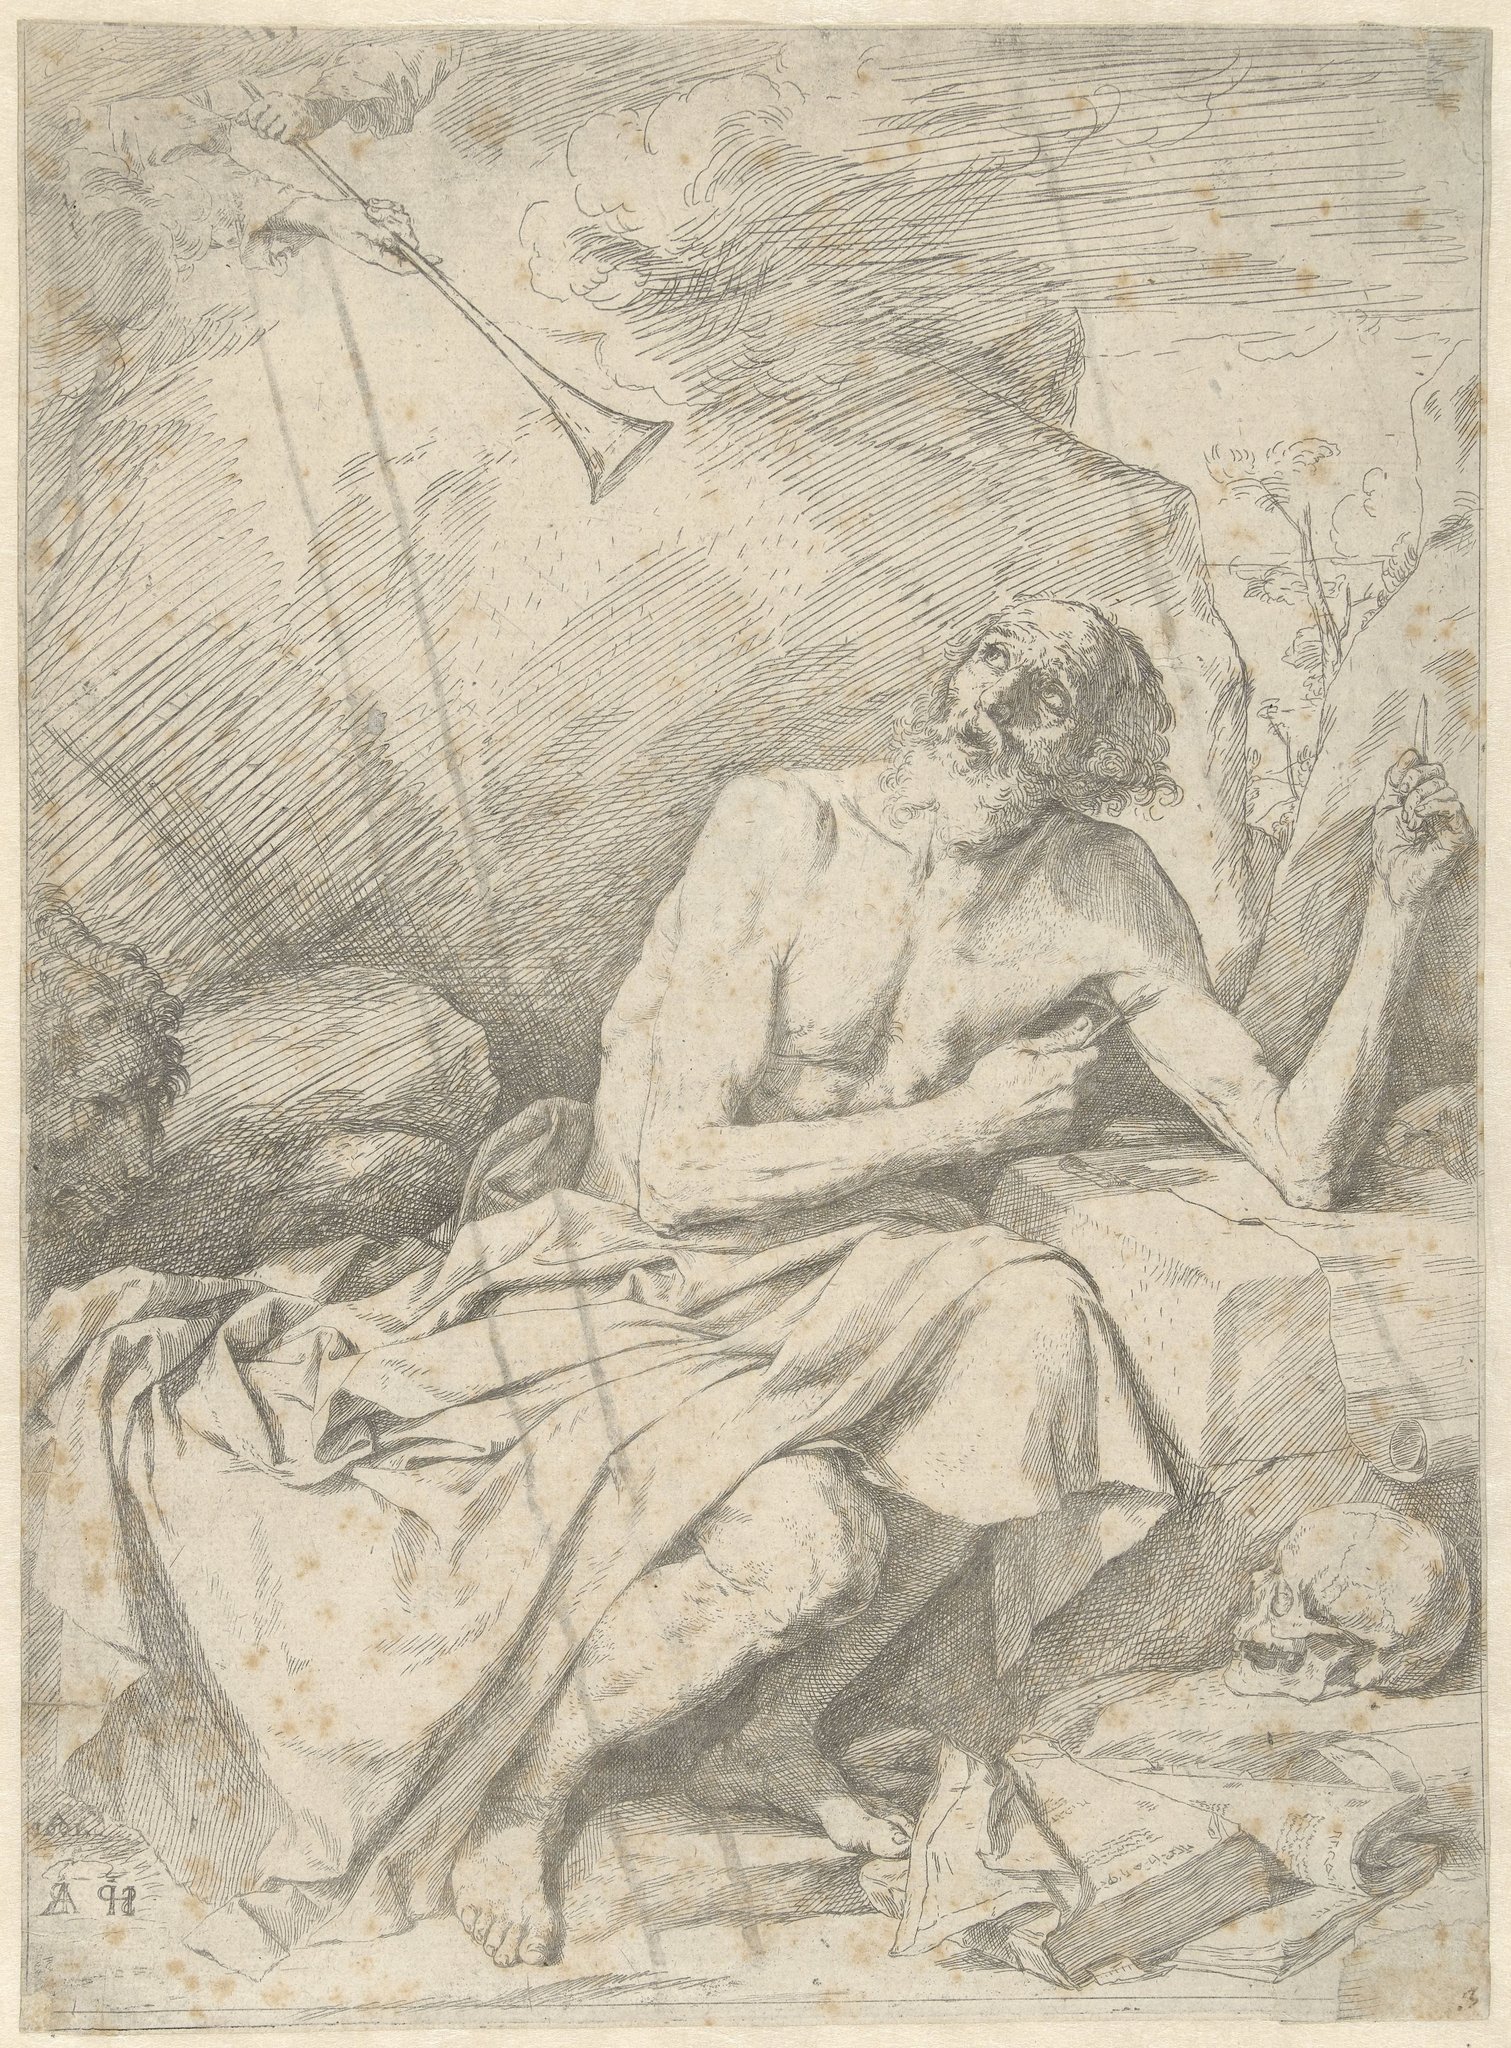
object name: print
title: Heilige Hieronymus en de trompet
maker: jusepe de ribera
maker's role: draughtsman, painter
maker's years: 1591-1652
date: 1621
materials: paper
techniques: printmaking, drypoint, engraving, etching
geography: naples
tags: st. jerome as penitent in the desert, half naked, kneeling before a crucifix and holding a stone in his hand to beat his breast; a skull (and other 'vanitas' symbols), sometimes a scorpion and a snake beside him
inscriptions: collector's mark: Lugt 10, number: ‘3’, collector's mark: Lugt 11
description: De heilige Hieronymus zittend in de wildernis, met zijn boeken, een schedel en de leeuw. Uit een wolk aan de hemel steken twee handen die een trompet vasthouden.